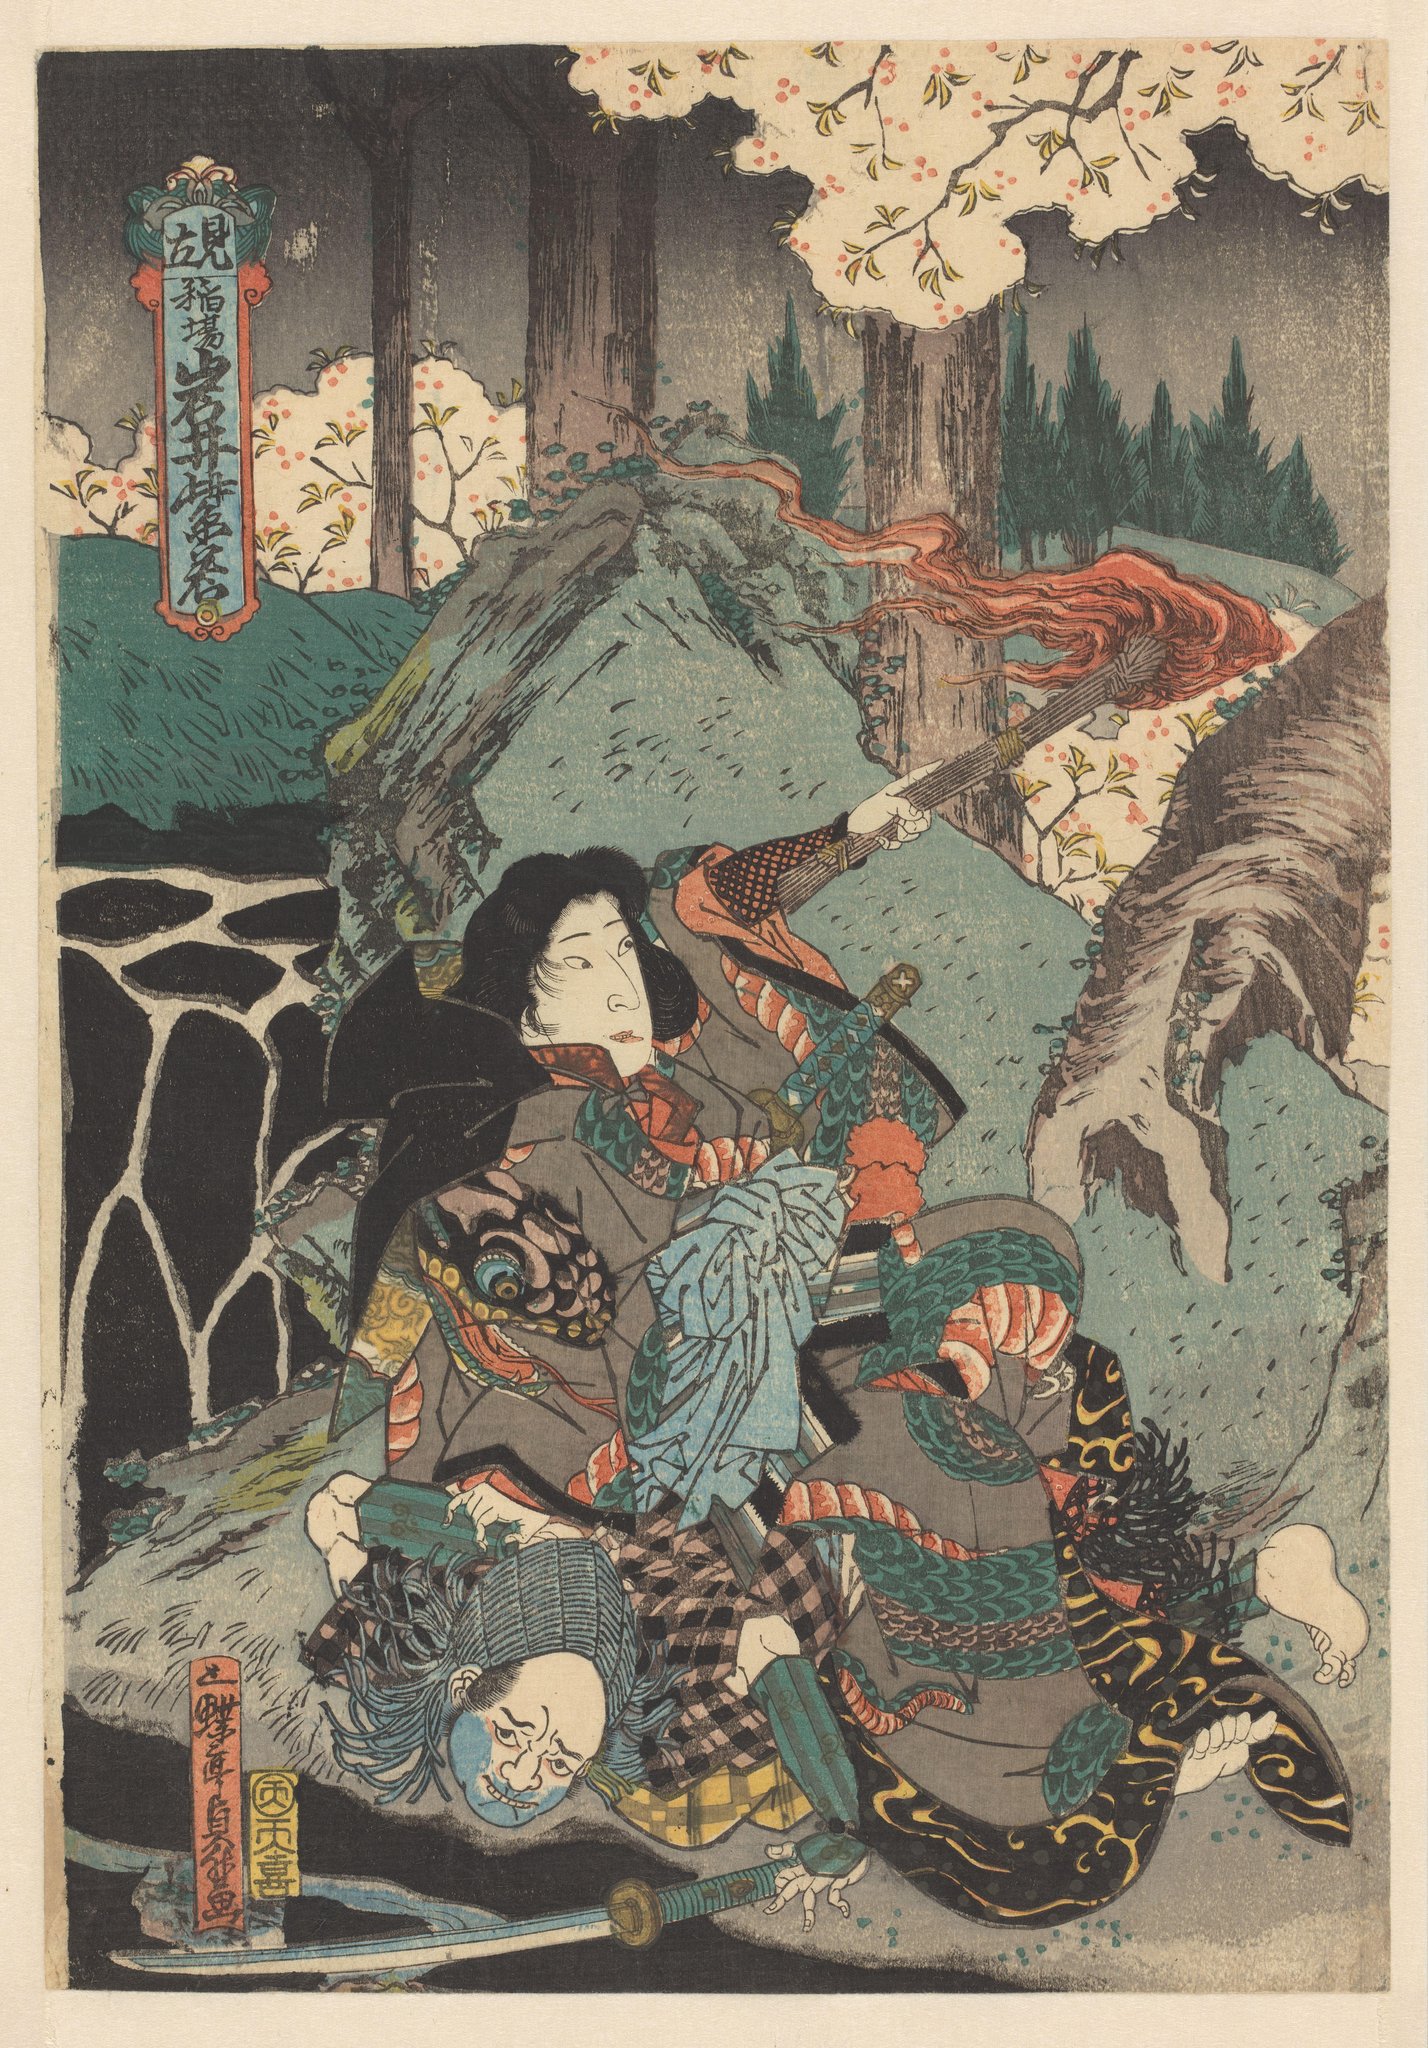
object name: print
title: Vierluik met vier toneelspelers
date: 1834-1835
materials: paper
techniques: woodcut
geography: japan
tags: japan, portrait of actor, actress, landscapes (+ landscape with figures, staffage), fighting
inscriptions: signature: ‘Gochôtei Sadamasu ga’, mark: ‘Tenki’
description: Linker blad van een vierluik v.l.n.r. Iwai Shijaku I als Inaba, Nakamura Shikan II als Inaba Tarô, Arashi Rikan II als Ushiwaka Saburô, en Nakamura Baigyoku I (Nakamura Utaemon III) als Tsujikaze Happei. In het midden van de scène ligt een reusachtige, overwonnen roofvogel.